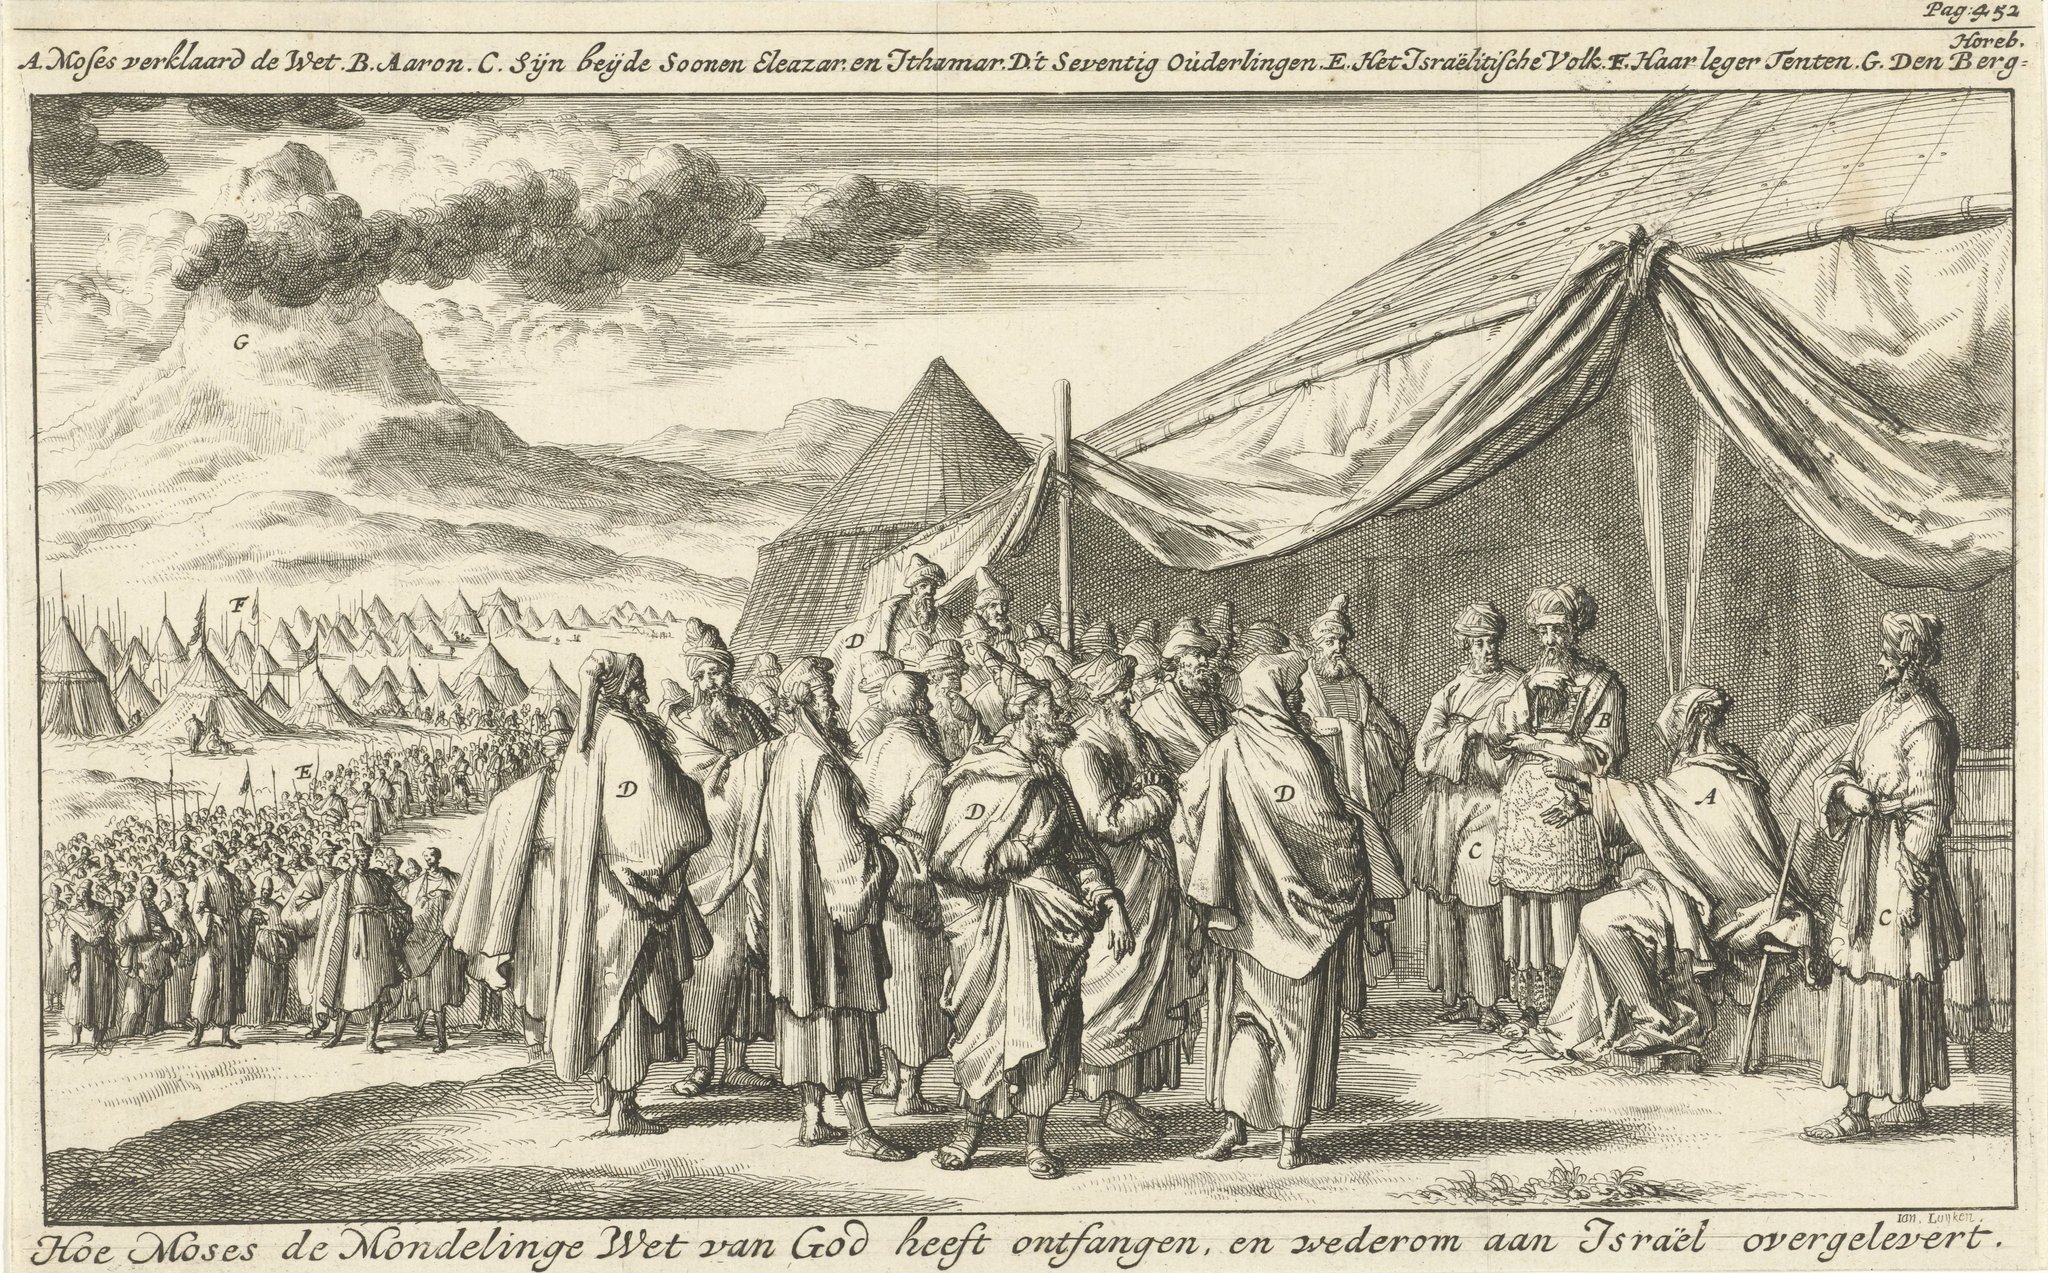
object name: book illustration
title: Mozes verkiest de zeventig oudsten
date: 1684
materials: paper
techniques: etching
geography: amsterdam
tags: moses chooses seventy elders to assist him and places them round the tabernacle; the spirit of god descends upon them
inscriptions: collector's mark: Lugt 2228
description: Illustratie uit: Aysma, Joannes. Spiegel der Sibyllen, van vierderley vertooningen. Amsterdam: Timotheus ten Hoorn, 1685.